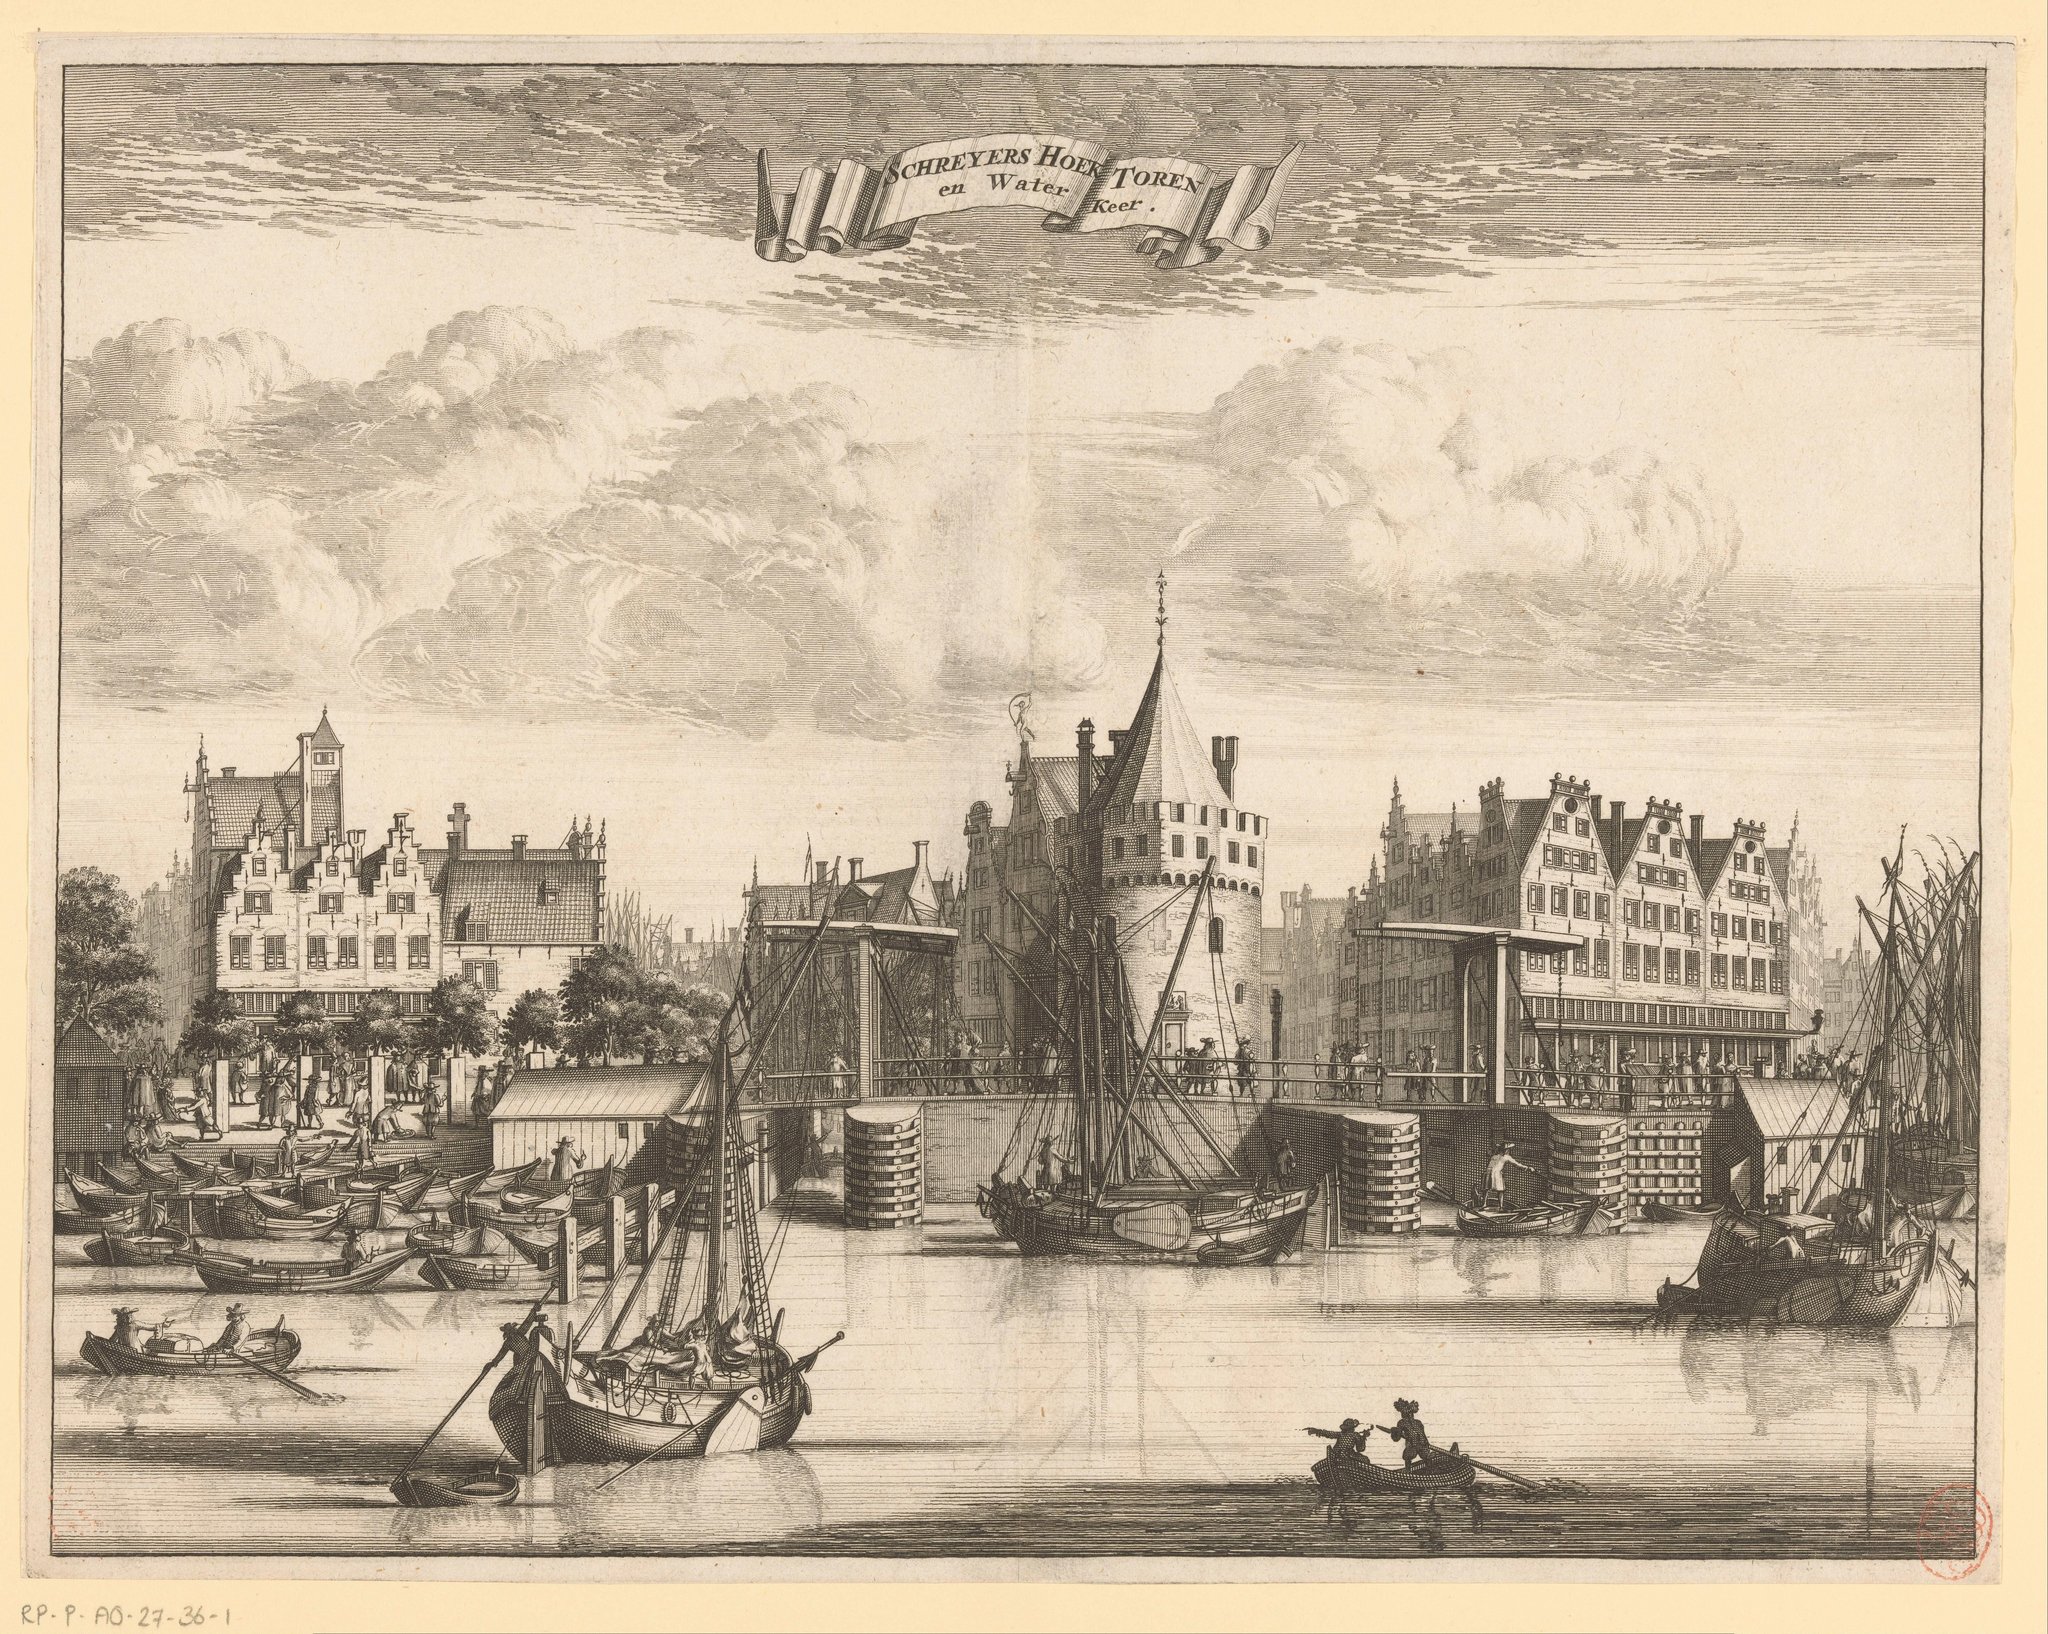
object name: print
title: Gezicht op de Schreierstoren te Amsterdam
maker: Anonymous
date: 1693-1694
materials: paper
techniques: engraving, etching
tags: bridge in city across river, canal, etc. (+ city(-scape) with figures, staffage), towers ~ fortified city, canals, waters (in city) (+ city(-scape) with figures, staffage), street (+ city(-scape) with figures, staffage)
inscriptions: collector's mark: Lugt 195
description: Huidige staat van prent ook gebruikt in: Commelin, Caspar. Beschryvinge van Amsterdam, desselfs eerste oorspronk uyt den Huyse (…). 2 delen. Amsterdam: Abraham Wolfgang, Gillis Janssonius van Waesberge, Johannes Janssonius van Waesberge II, weduwe Dirk Boom I, Hendrick Boom en Rembertus Goethals, 1693. En in: Commelin, Caspar. Beschryvinge van Amsterdam, zynde een naukeurige verhandelinge van desselfs eerste oorspronk uyt (…). 2 delen. Amsterdam: weduwe Aart Dircksz Oossaan, 1694. Latere staat ook gebruikt in: Commelin, Caspar. Beschryvinge van Amsterdam, zynde een naukeurige verhandelinge van desselfs eerste oorspronk uyt (…). 2 delen. 2e druk. Amsterdam: Andries van Damme, Johannes Ratelband, weduwe A. van Aaltwyk en Hermanus Uytwerf, 1726.